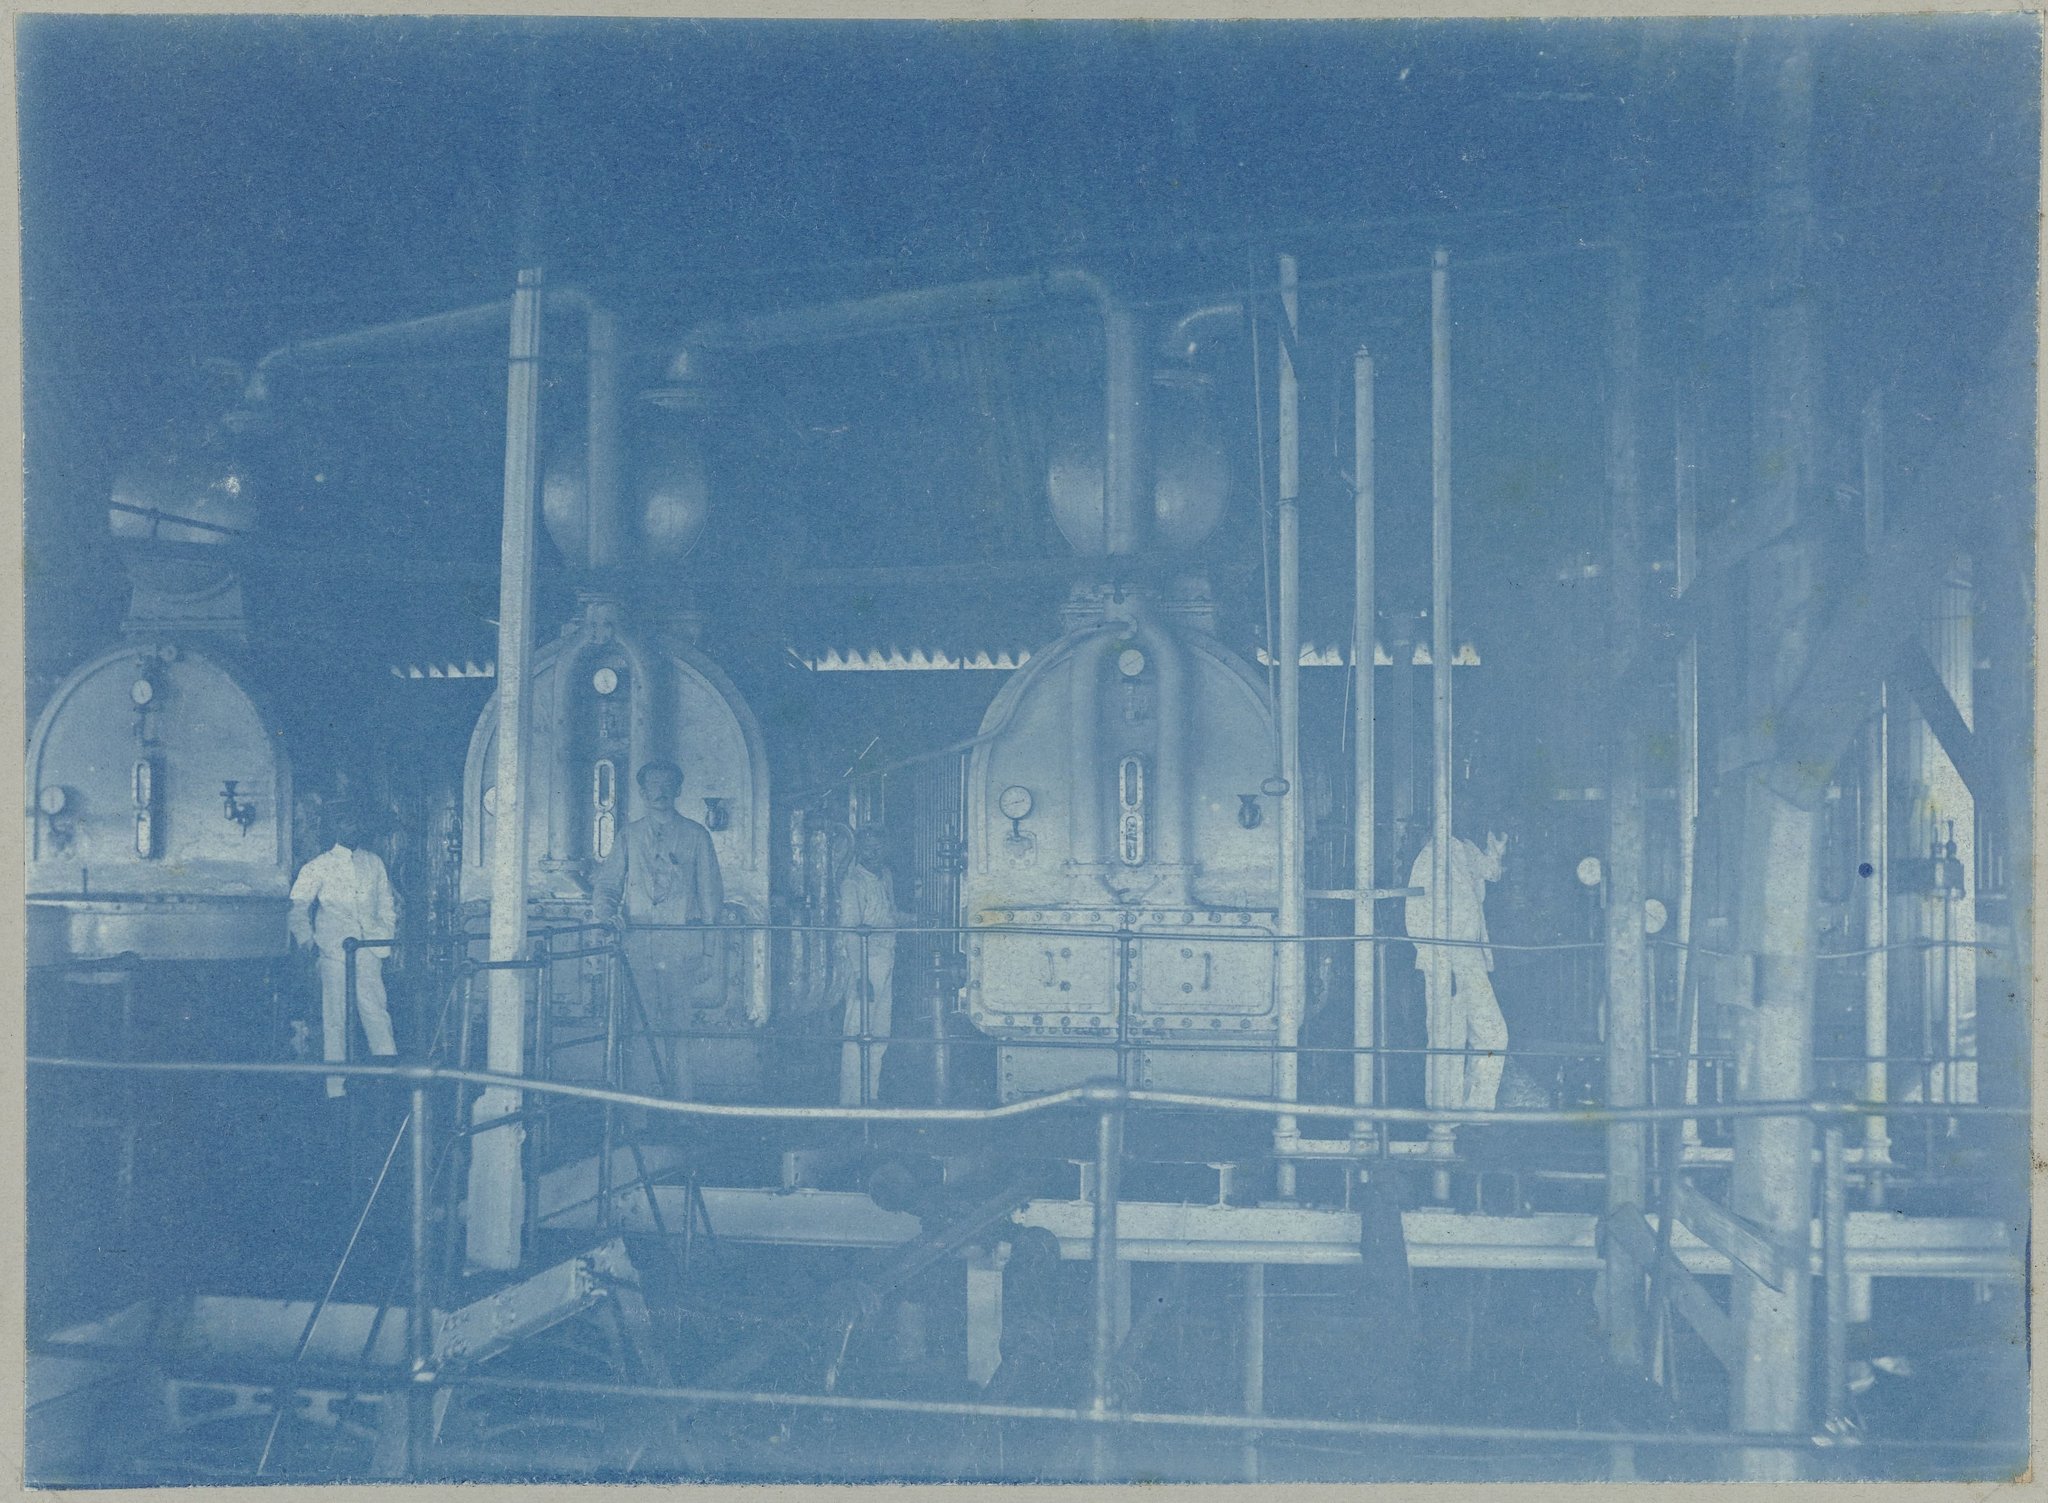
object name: photograph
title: In Rust en werk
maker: hendrik doijer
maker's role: engineer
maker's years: 1863-1925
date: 1903-1910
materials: photographic support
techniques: cyanotype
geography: suriname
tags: suriname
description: Gezicht in de suikerfabriek op de Plantage Rust en Werk, vier mannen staande bij de ketels. Onderdeel van het fotoalbum Souvenir de Voyage (deel 2), over het leven van de familie Doijer in en rond de plantage Ma Retraite in Suriname in de jaren 1903-1910.